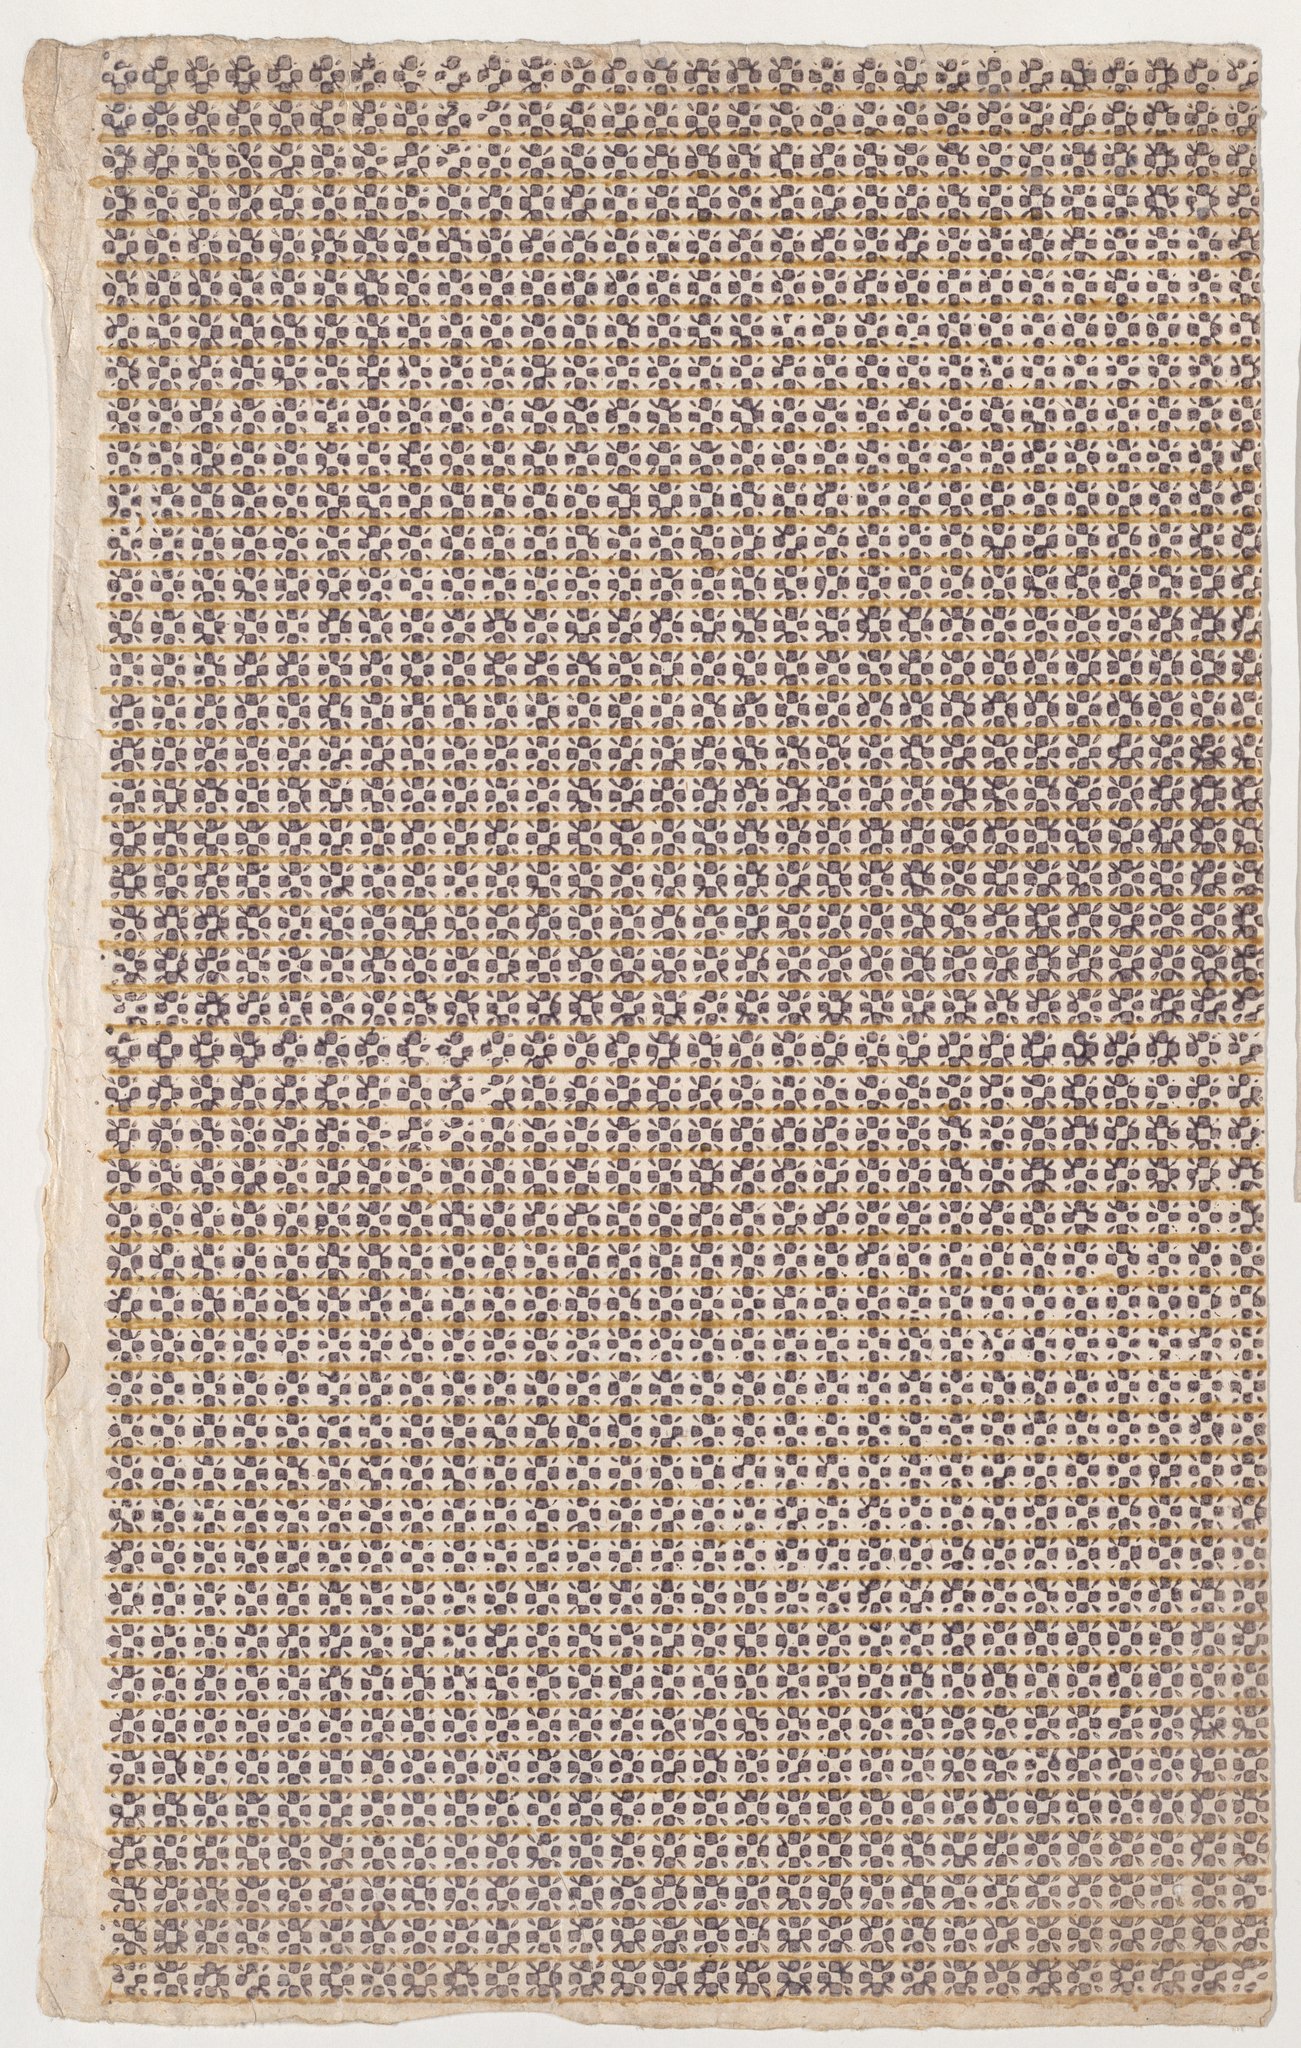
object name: print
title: Sheet with overall abstract pattern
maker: Anonymous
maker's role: artist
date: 1801-1900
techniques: relief print